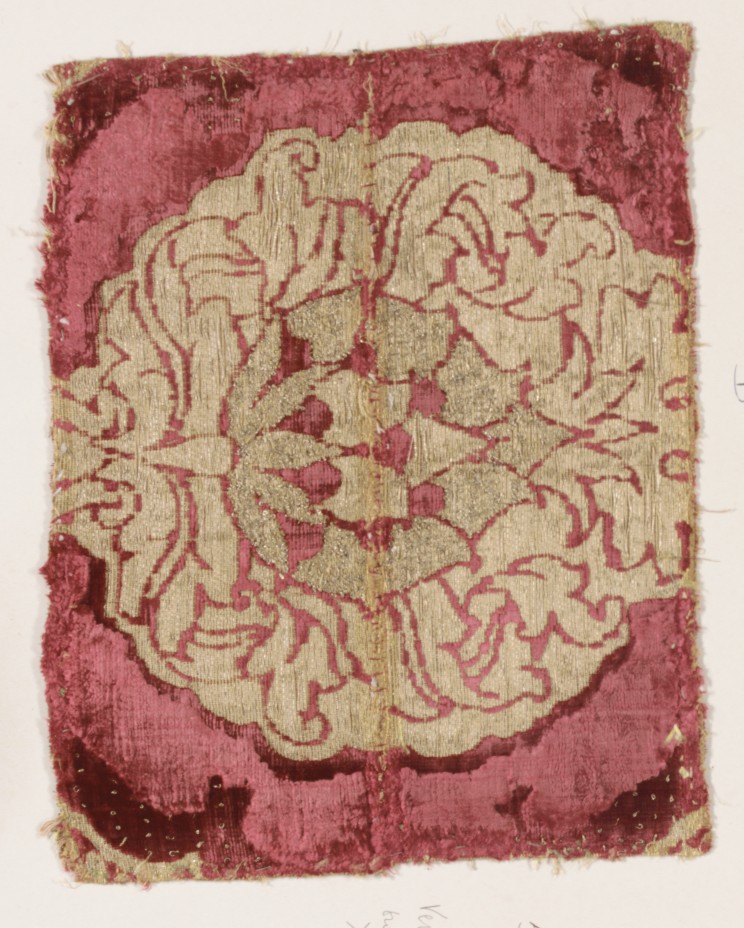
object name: fragment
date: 1401-1600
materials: metal thread, silk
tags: flowers